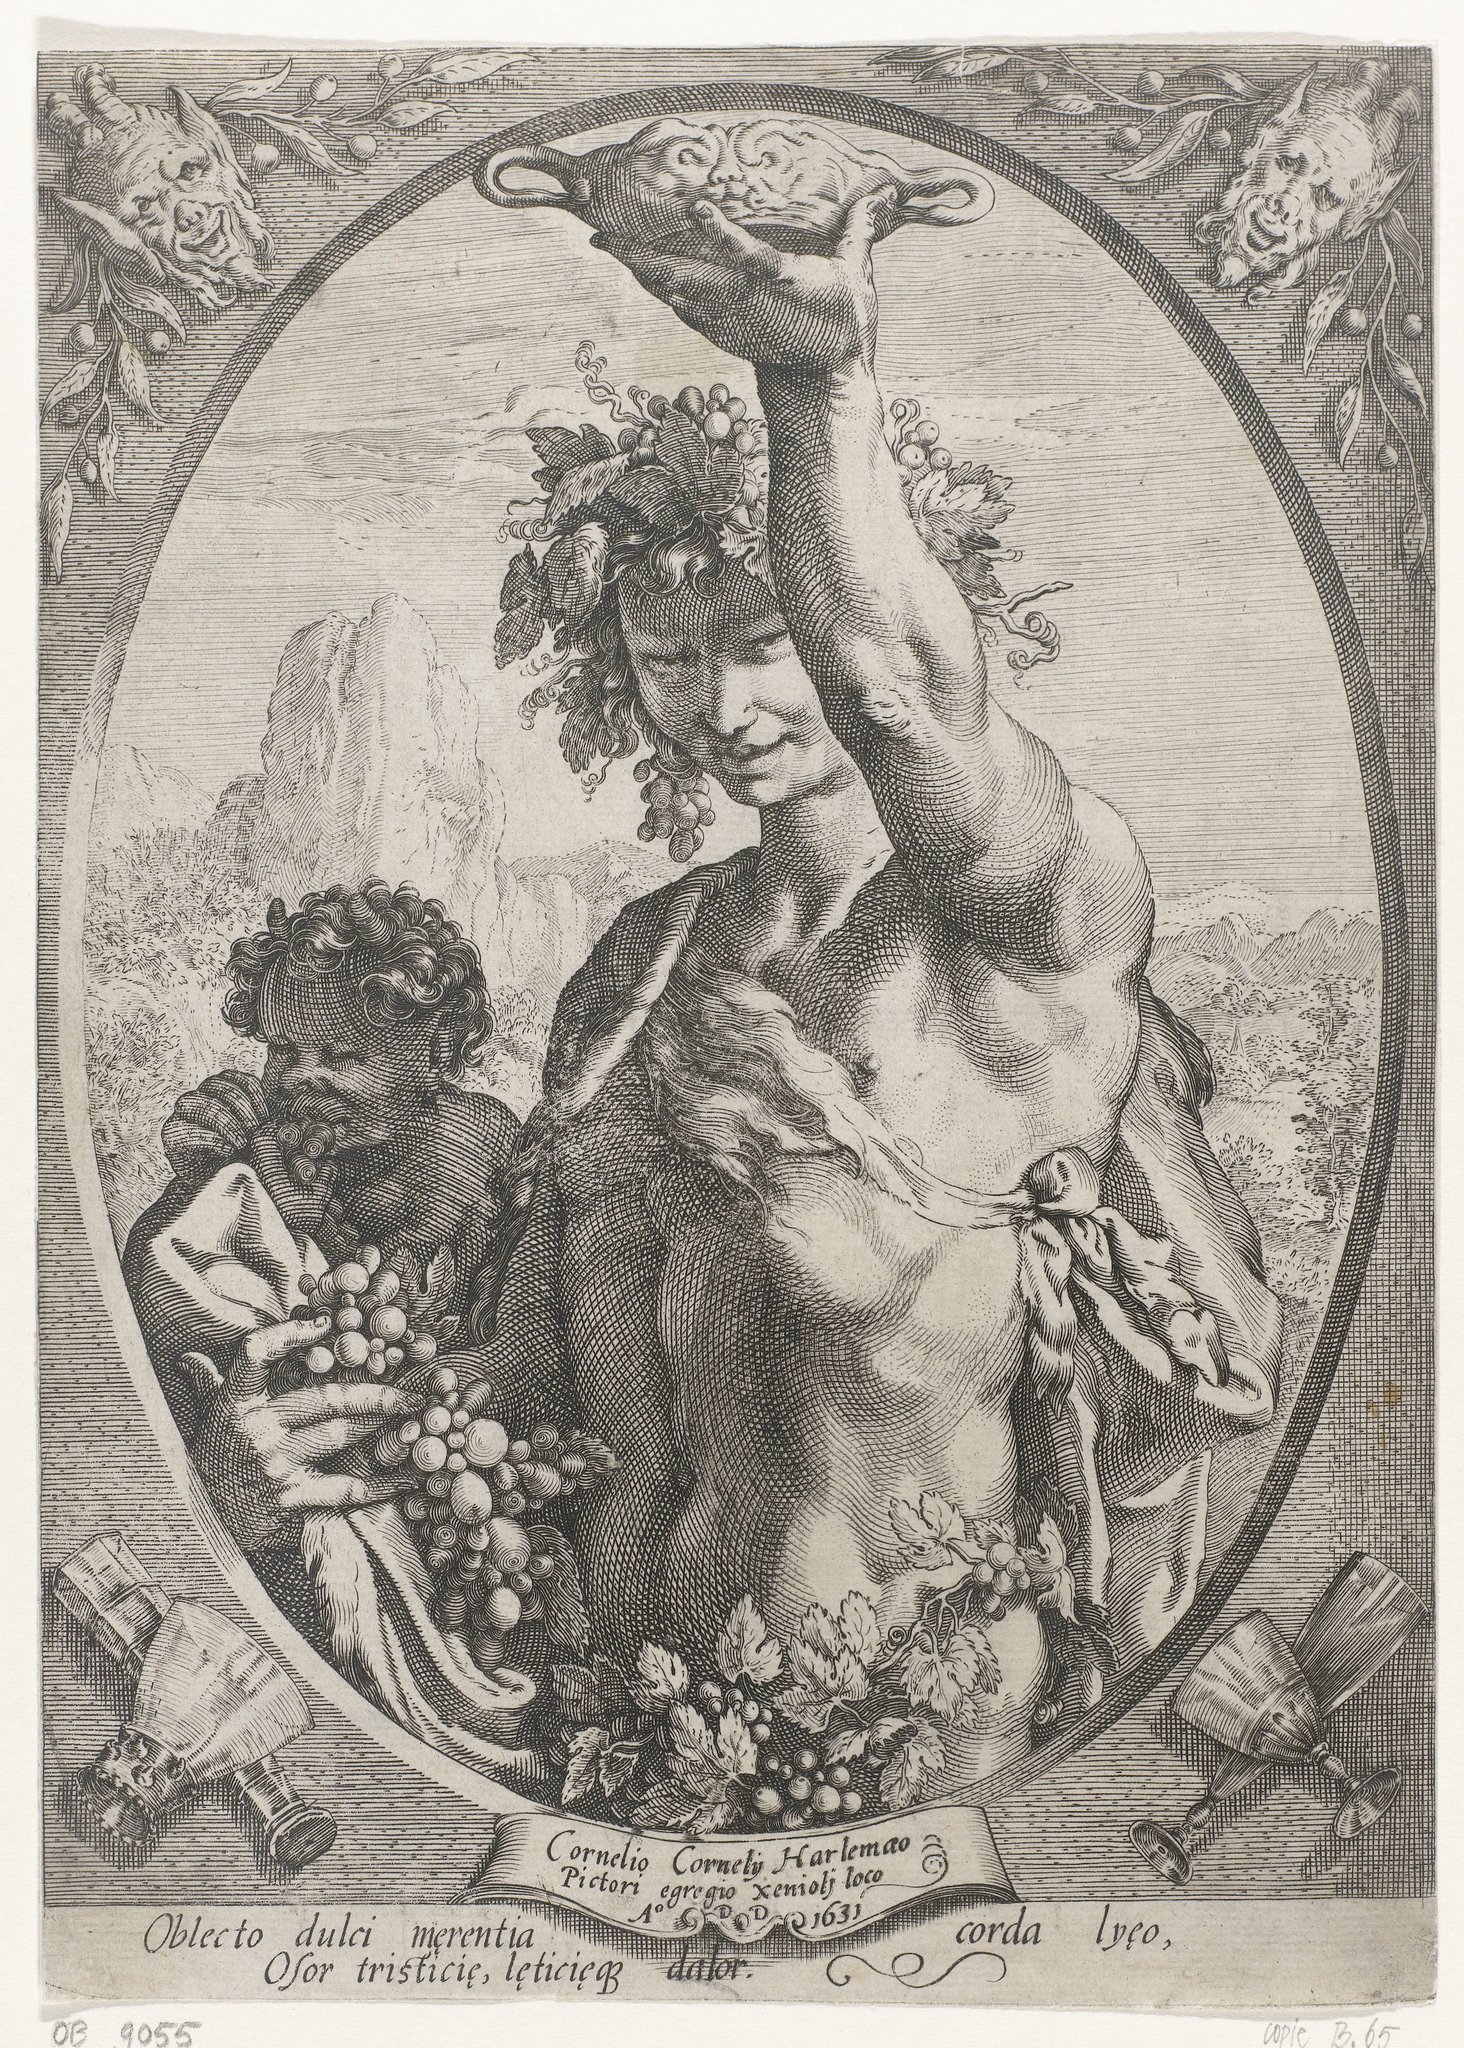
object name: print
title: Bacchus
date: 1631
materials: paper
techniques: engraving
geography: haarlem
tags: (story of) bacchus (dionysus), liber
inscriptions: collector's mark: Lugt 2228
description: Bacchus heft zijn drinknap. Hij draagt een kroon van druiven en wingerdbladeren op zijn hoofd en een geitenhuid om zijn schouders. Achter hem een druiven etende sater. De bovenhoeken van de lijst zijn versierd met de hoofden van saters, de onderhoeken met drinkglazen.